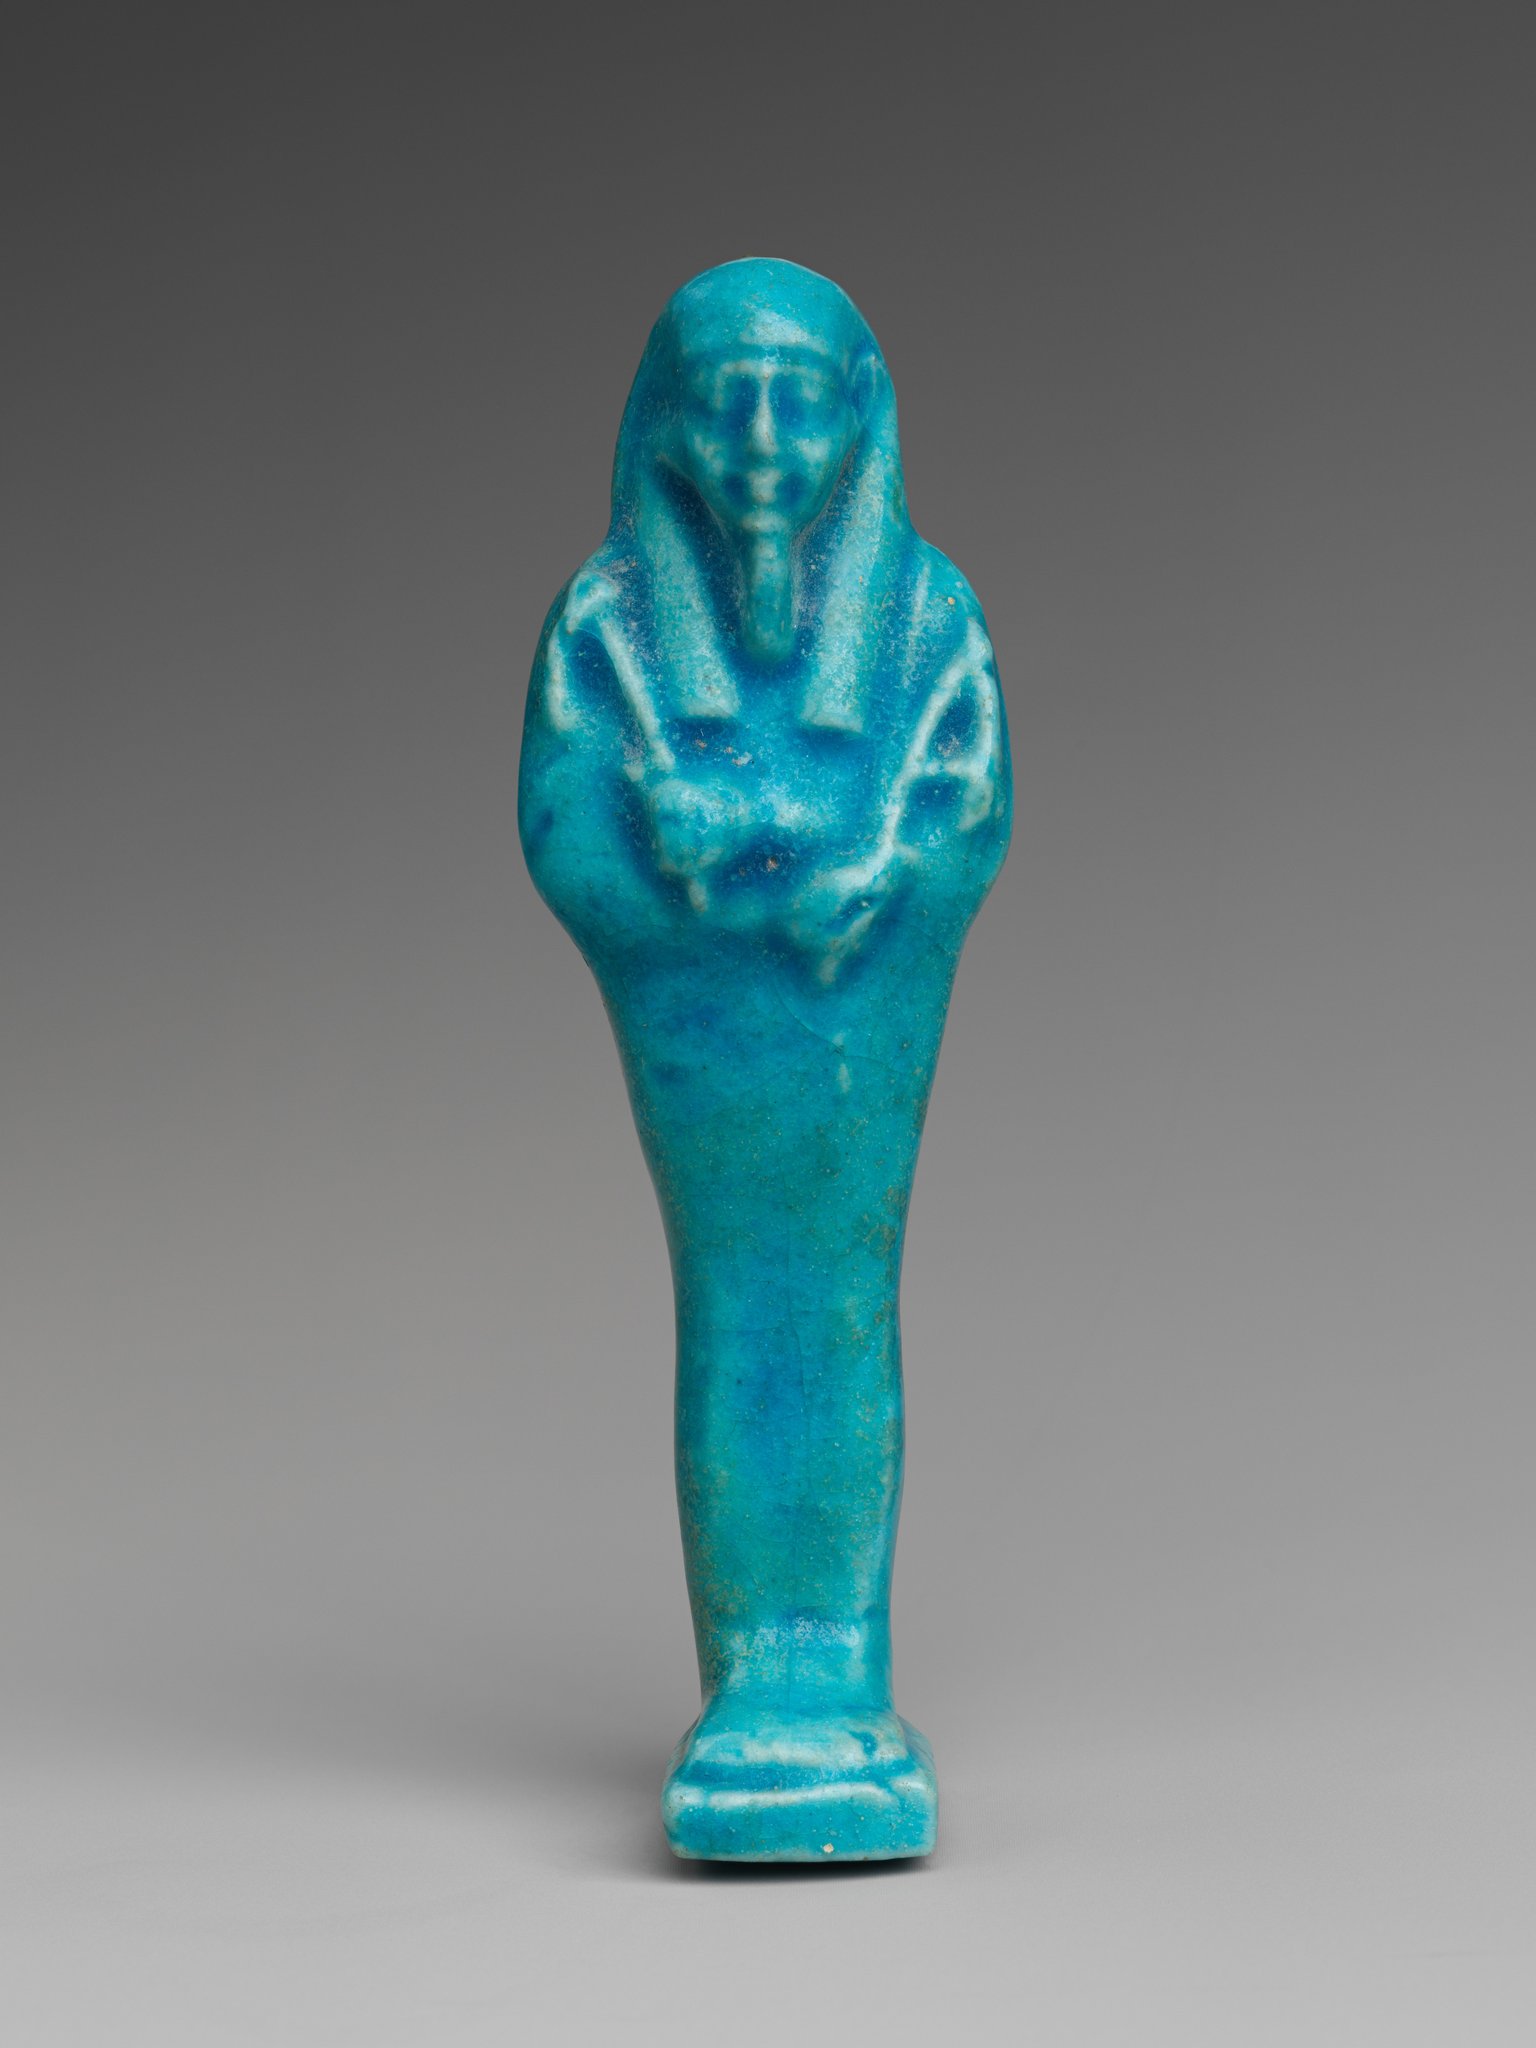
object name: shabti, petosiris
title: Shabti of Petosiris, son of Djedhor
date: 360-300 BCE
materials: faience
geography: egypt